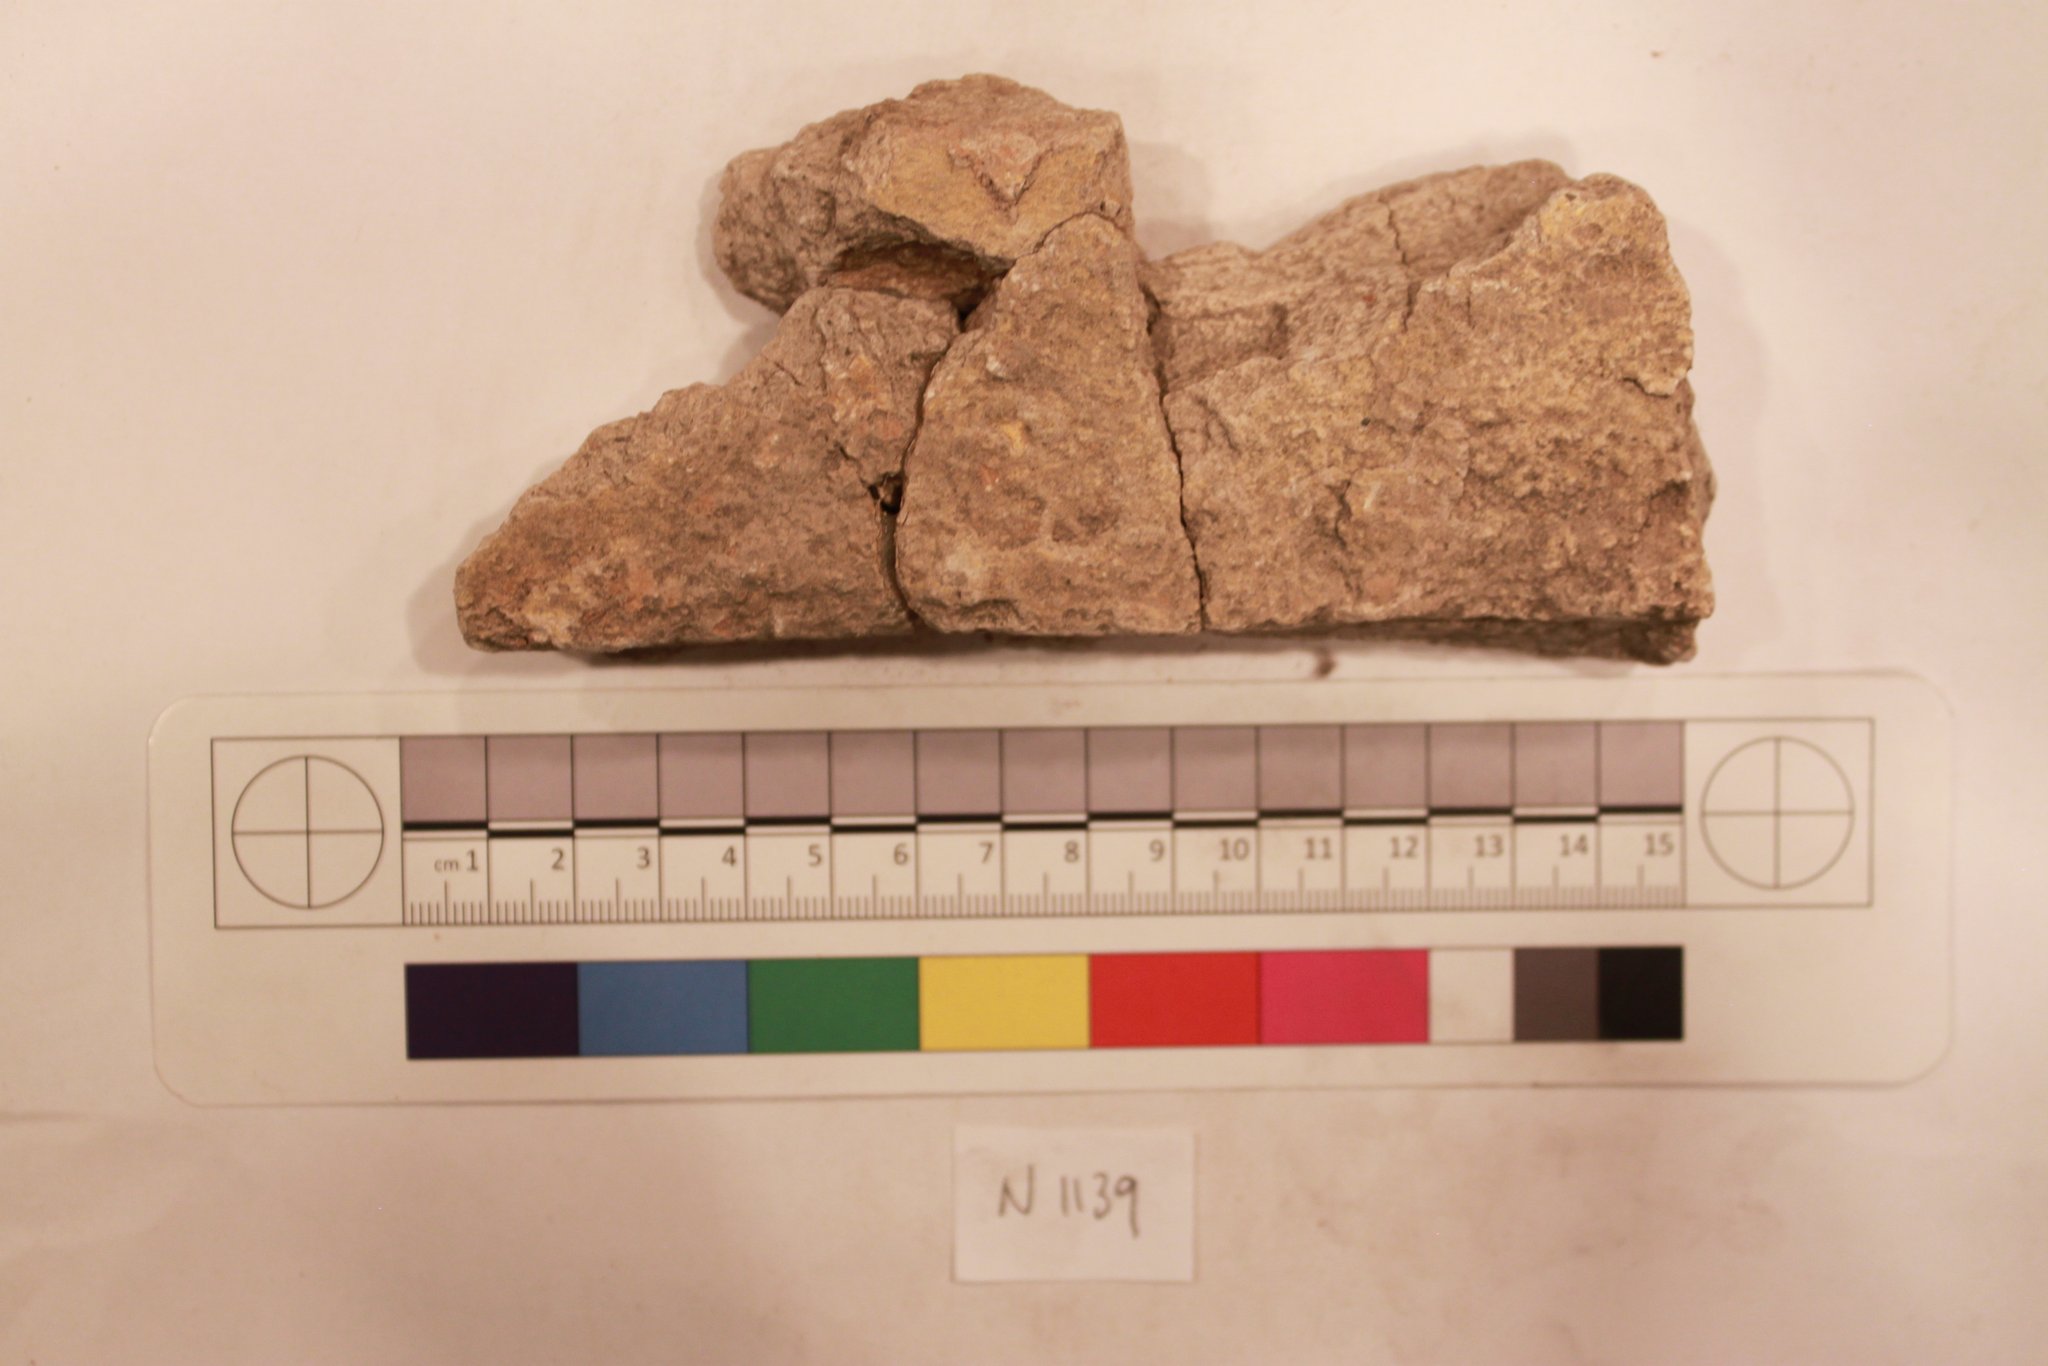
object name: fragment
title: Stucco Fragment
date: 701-1200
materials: plaster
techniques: carving, painting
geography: iran